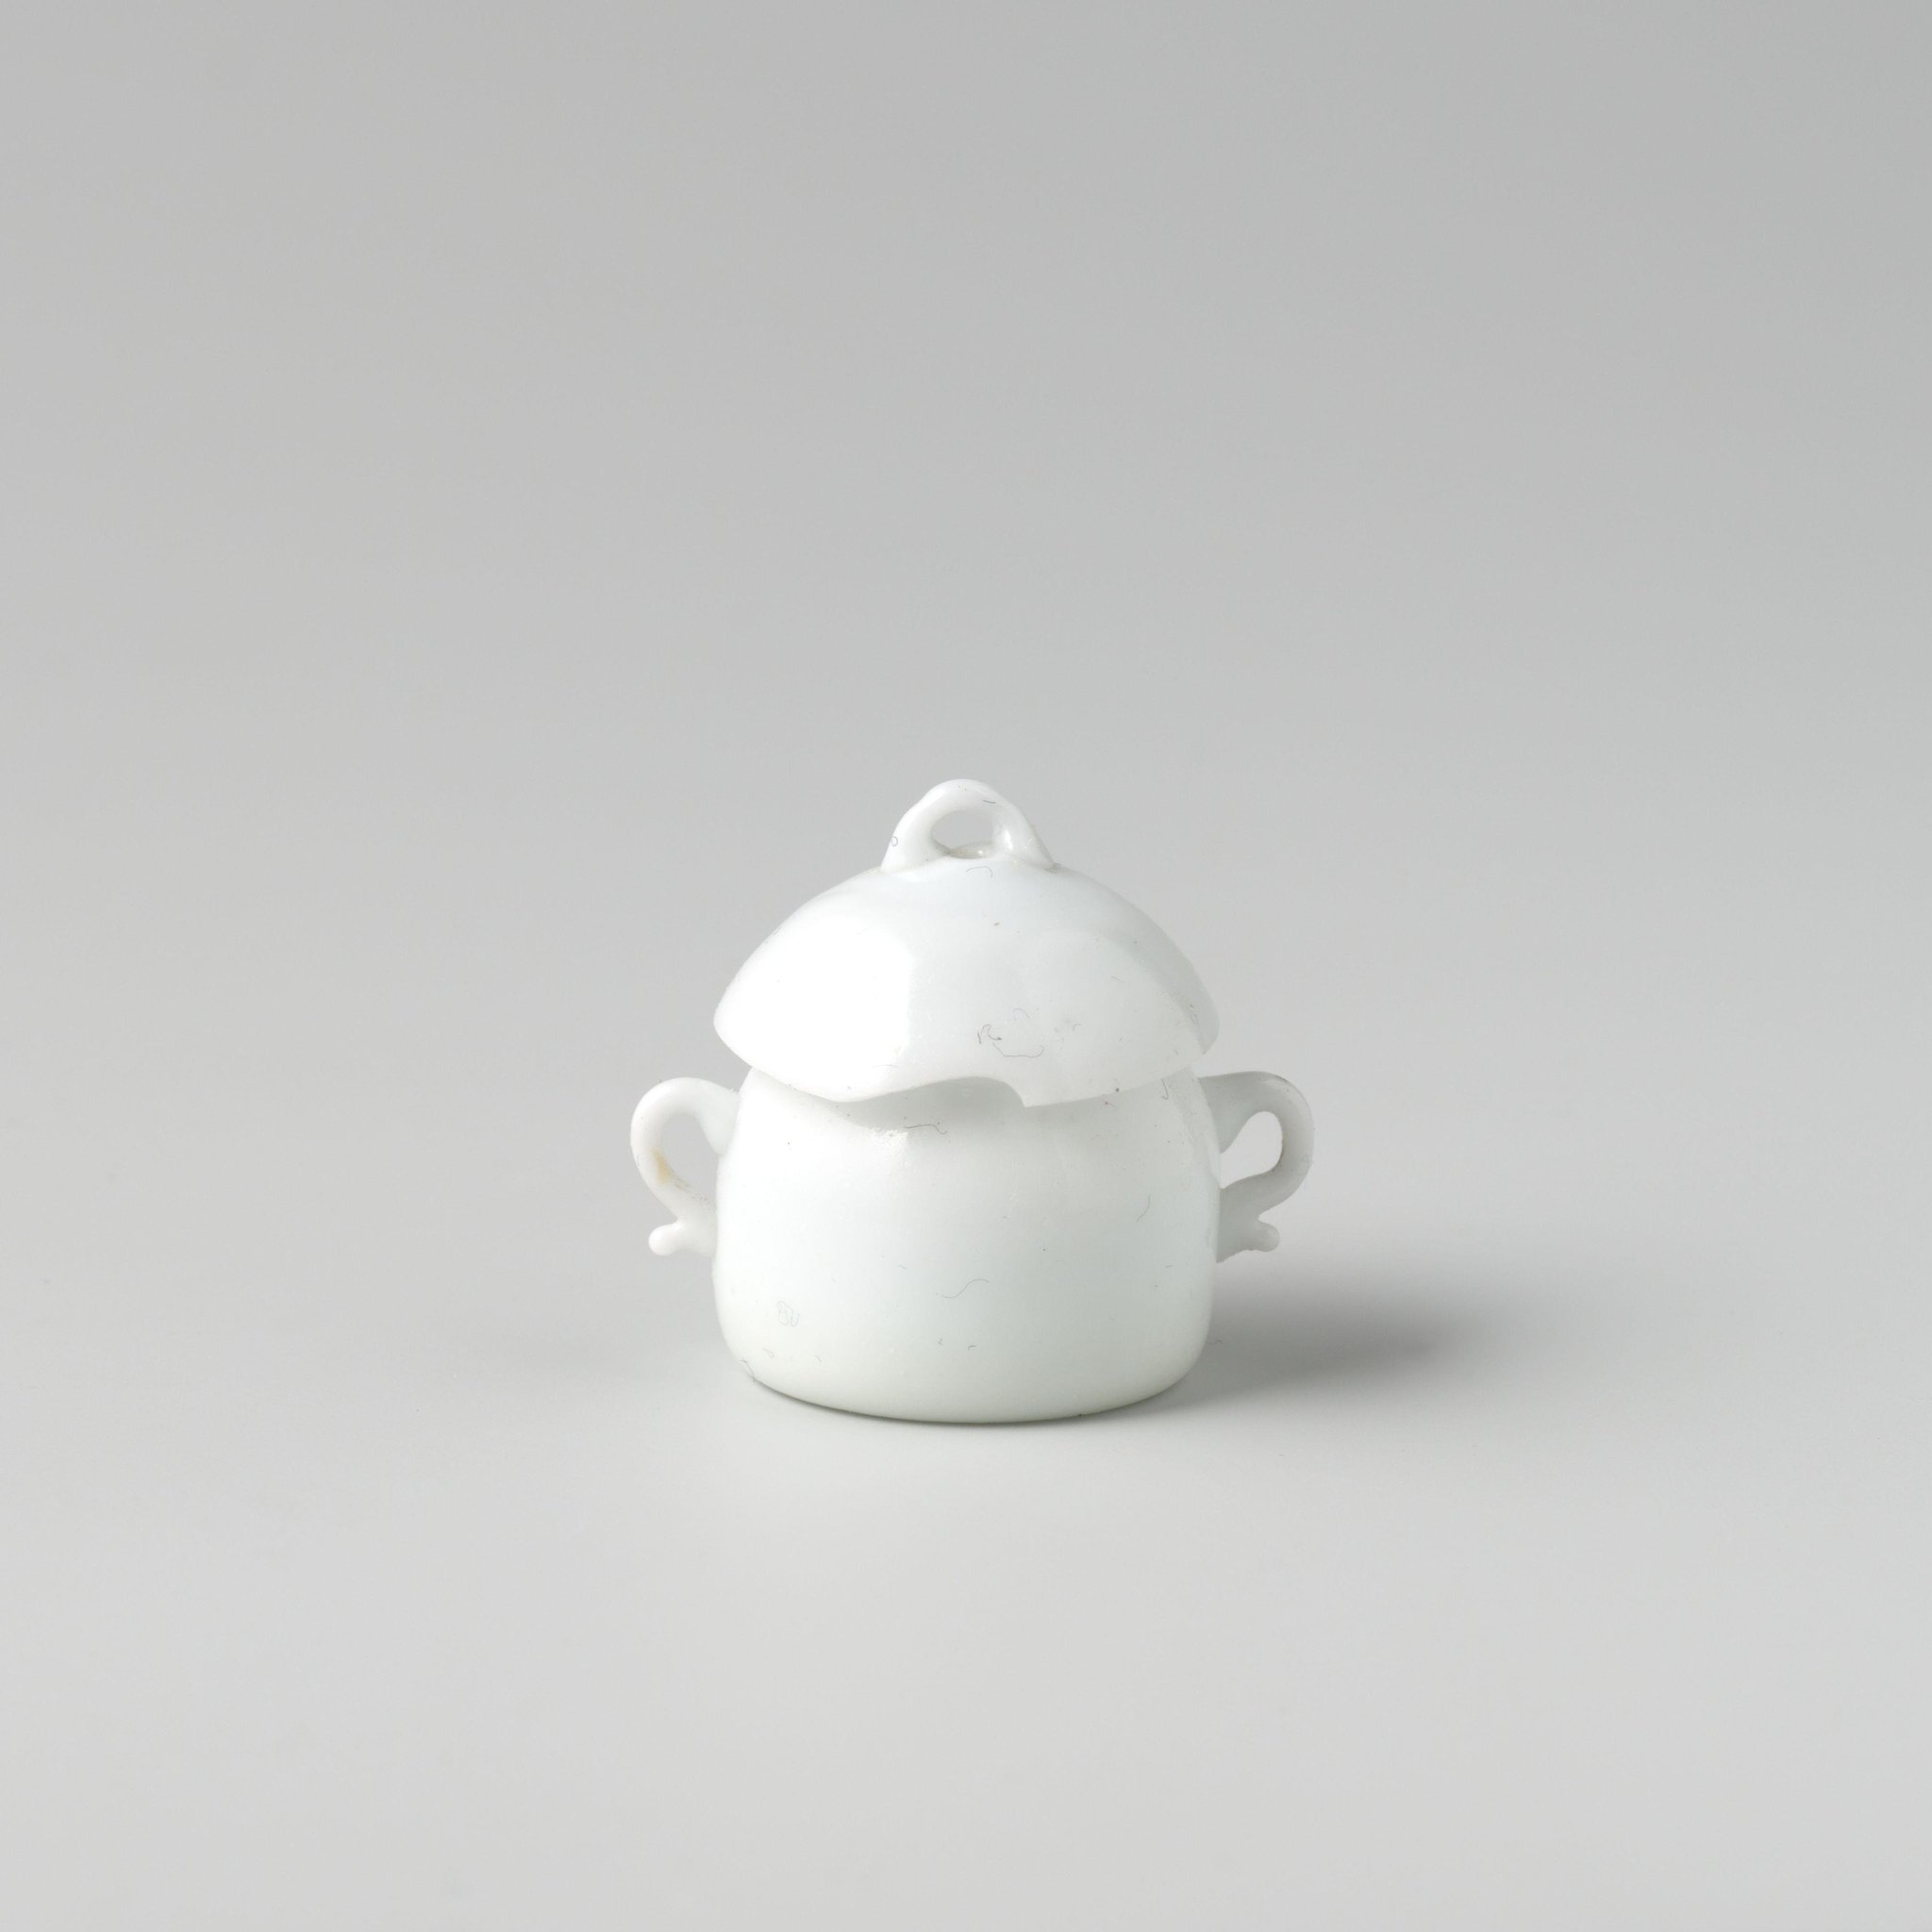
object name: miniature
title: Dekselpot van opaak wit glas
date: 1675-1700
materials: glass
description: Dekselpot van opaak wit glas, cilindrische model met naar binnen gestoken bodem en twee aangezette oren, deksels dubbelwandig en verschillend van vorm met knop of oor.